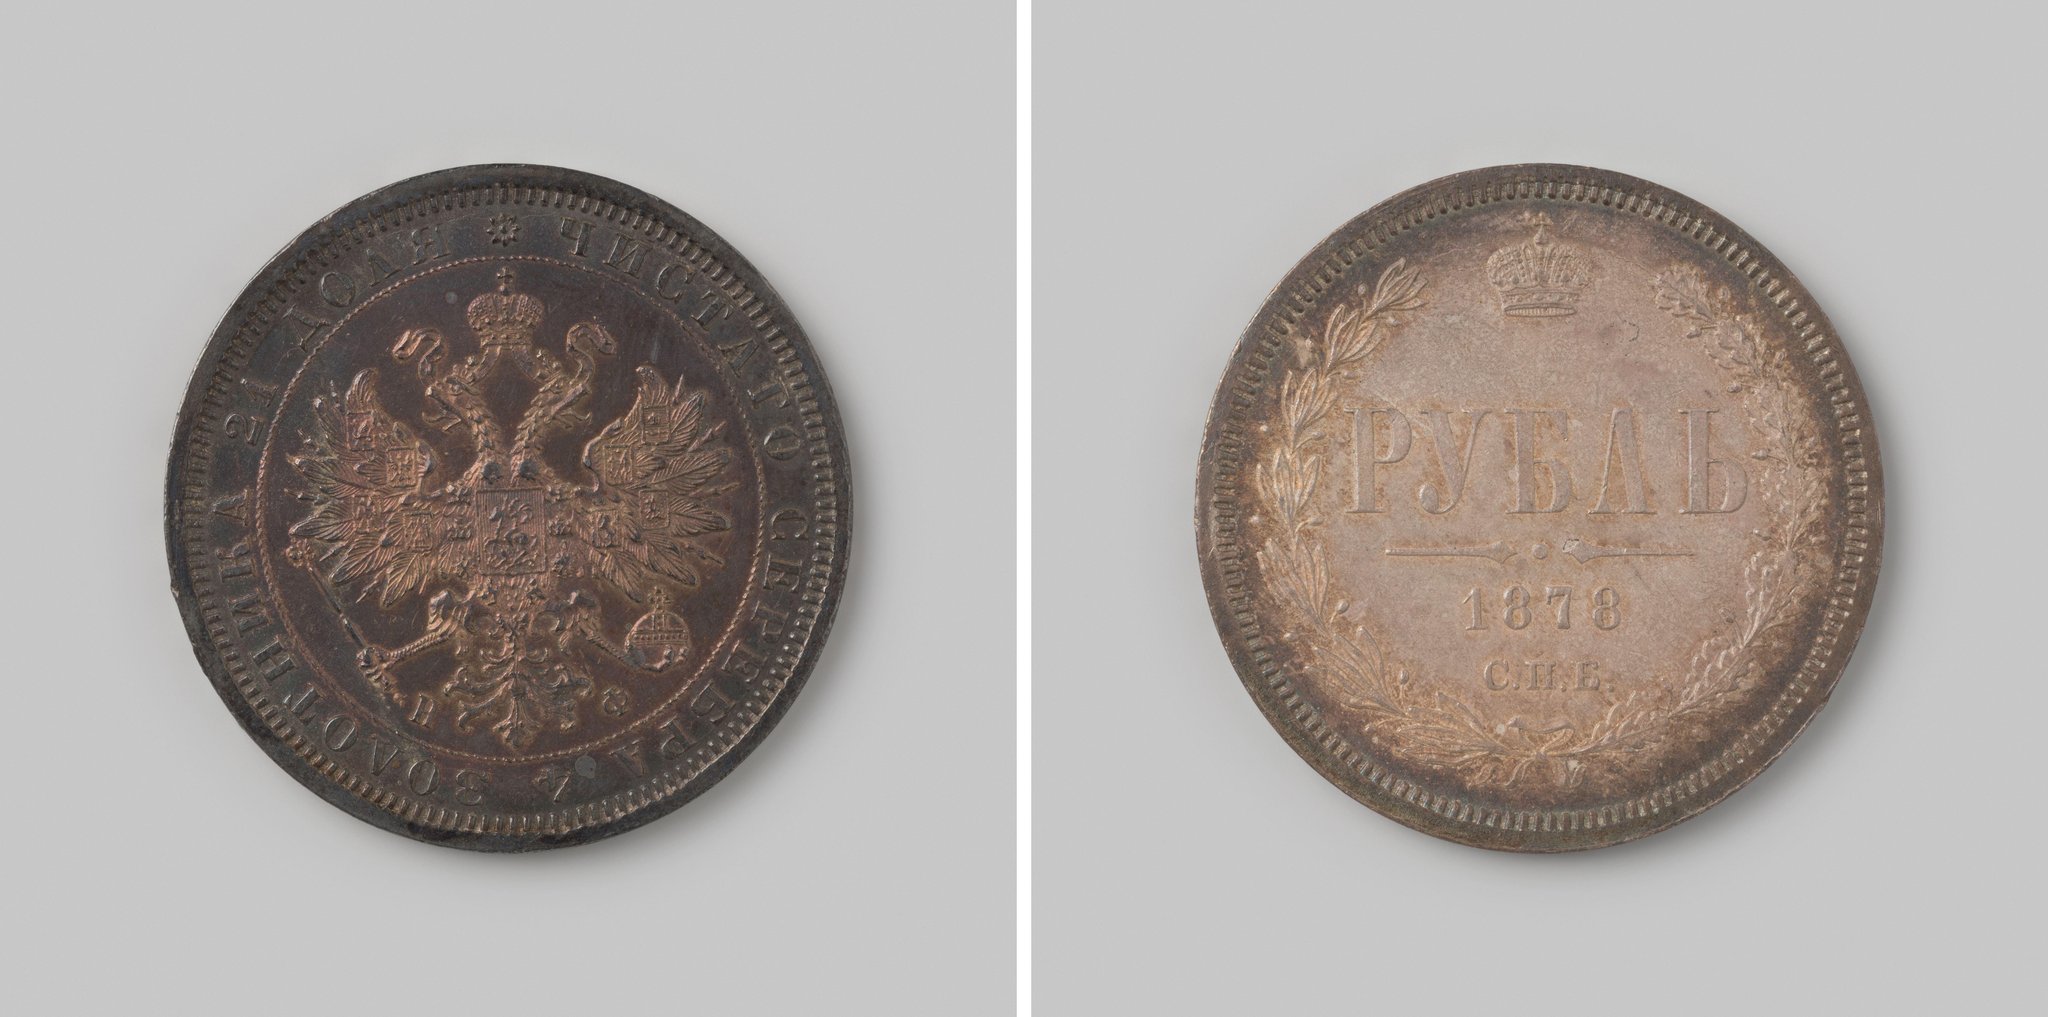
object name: coin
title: Rusland, tsaar Alexander II, roebel, 1878 SPB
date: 1878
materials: silver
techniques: striking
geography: sint-petersburg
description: Zilveren munt. Voorzijde: dubbelkoppige gekroonde adelaar met gespreide vleugels en met op zijn vleugels kleine wapenschilden en op zijn borst een groot, met een ridderorde omhangen wapenschild en in zijn poten een scepter en een gekroonde bol. Boven de adelaar een kroon met lint. Keerzijde: tussen twee samengebonden takken een kroon, waaaronder in een regel de waarde-aanduiding. Daaronder jaartal, waaronder in het Cyrillisch de letters S,P en B [=Sint Petersburg]. Randschrift.